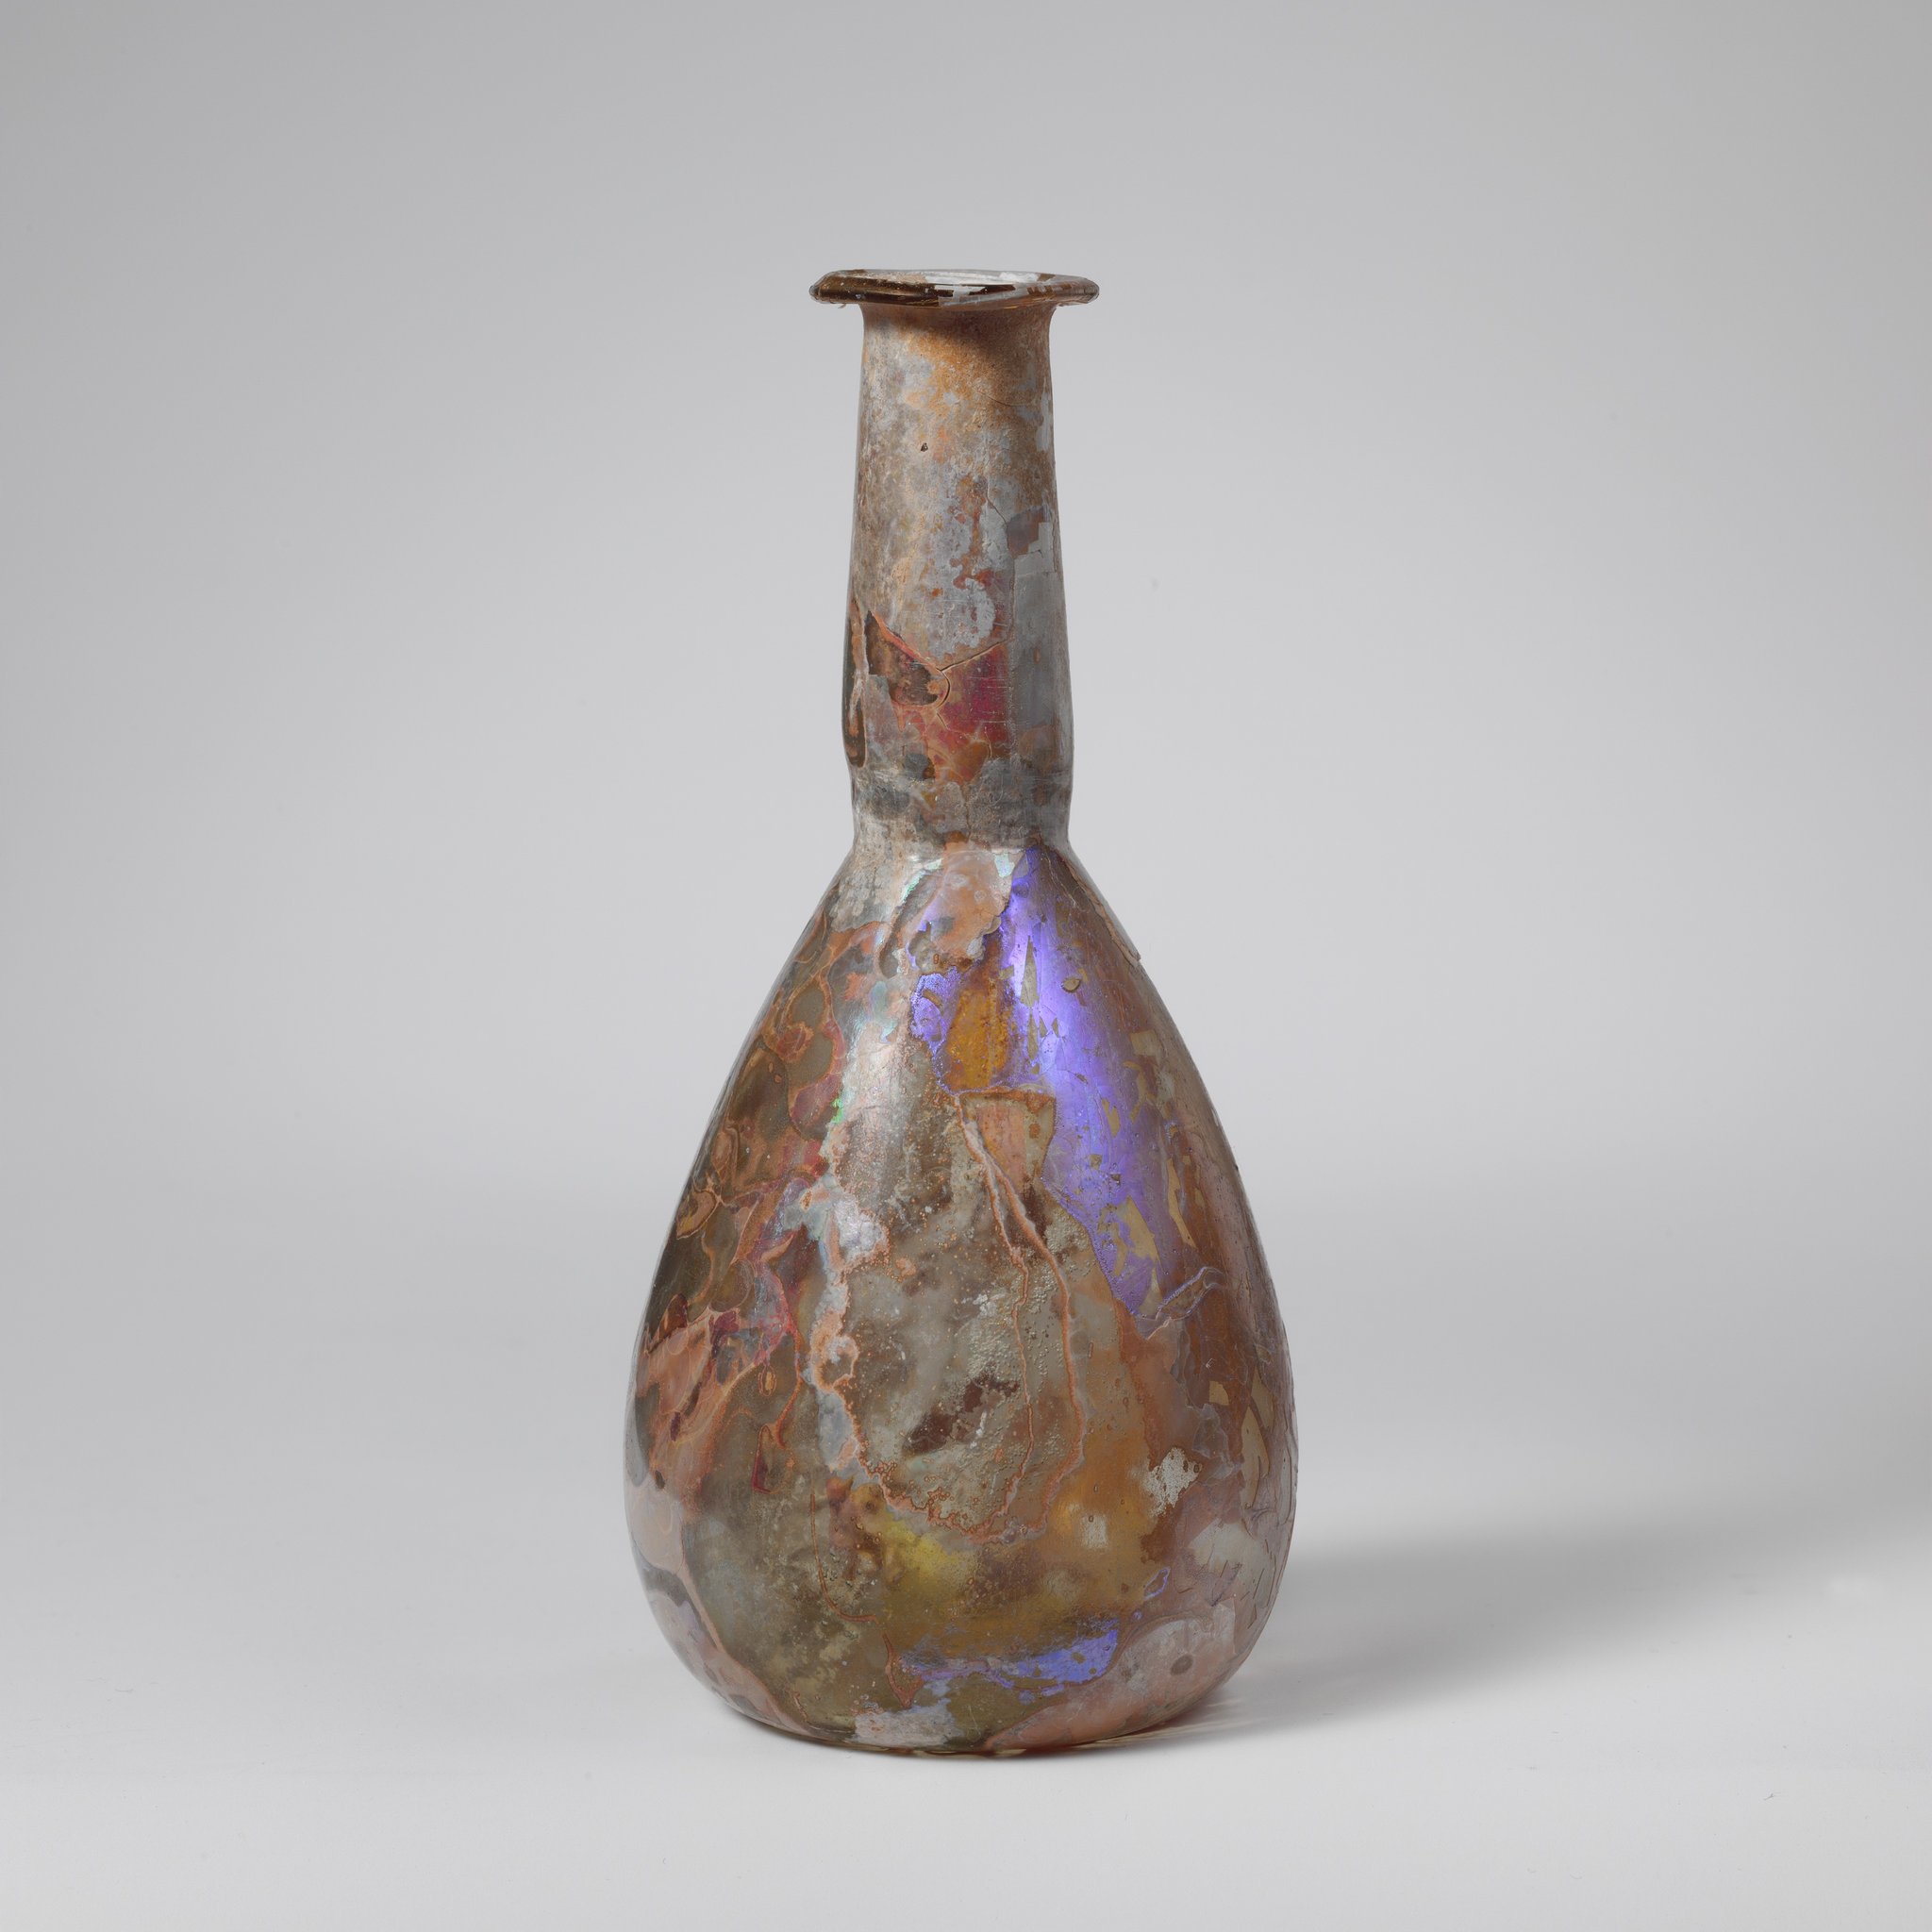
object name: perfume bottle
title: Glass perfume bottle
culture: roman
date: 101-300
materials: glass